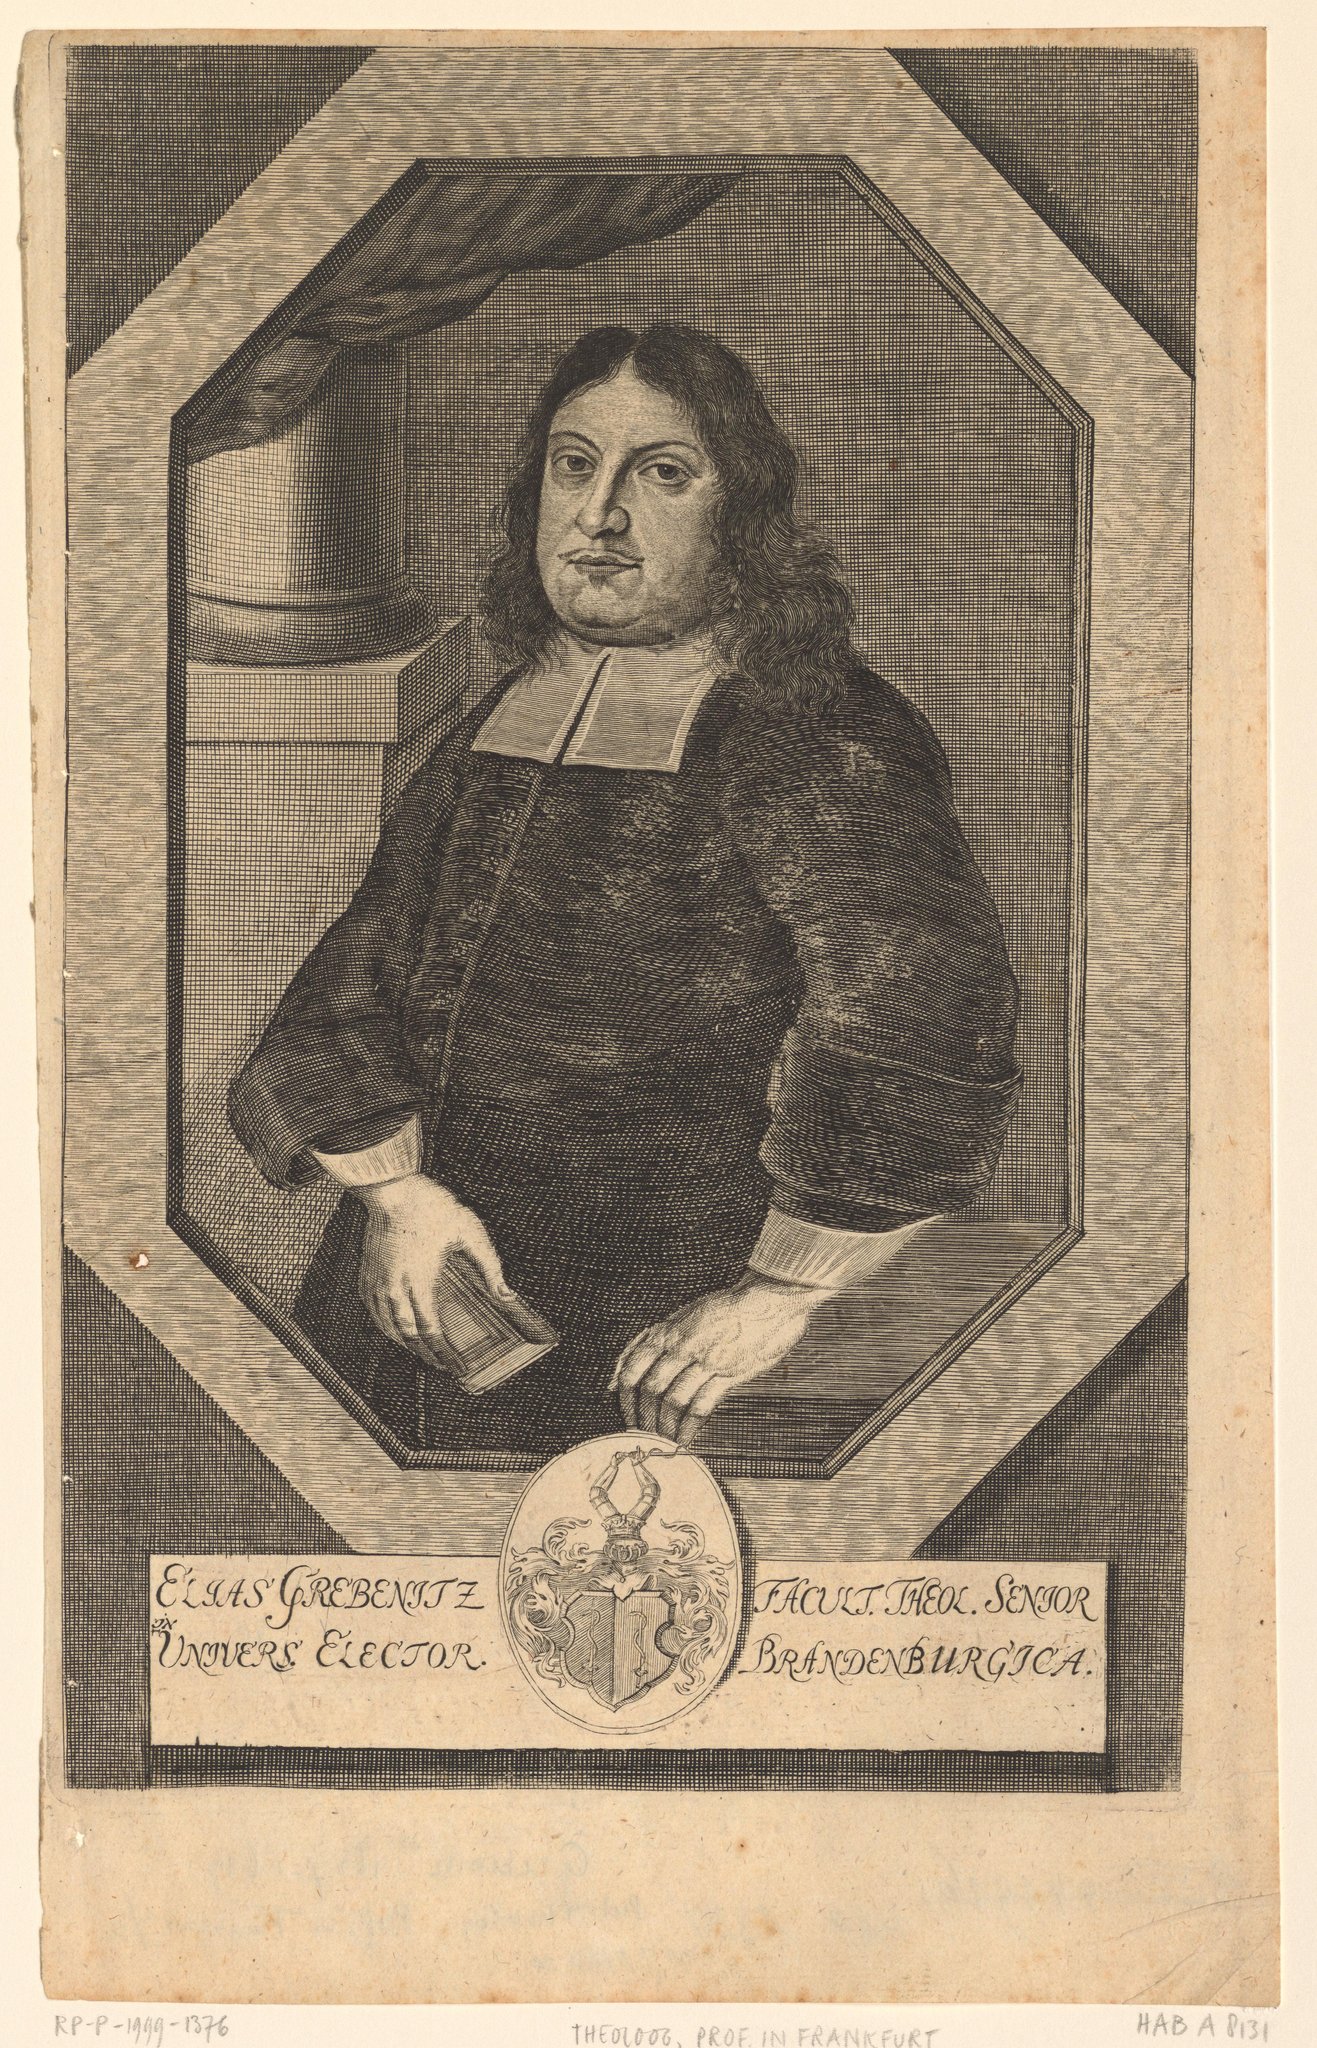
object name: print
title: Portret van Elias Grebenitz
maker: heinrich jakob otto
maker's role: print maker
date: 1650-1750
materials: paper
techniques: engraving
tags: theologian, historical persons, professor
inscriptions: collector's mark: Lugt 2228, collector's mark: Lugt 2760